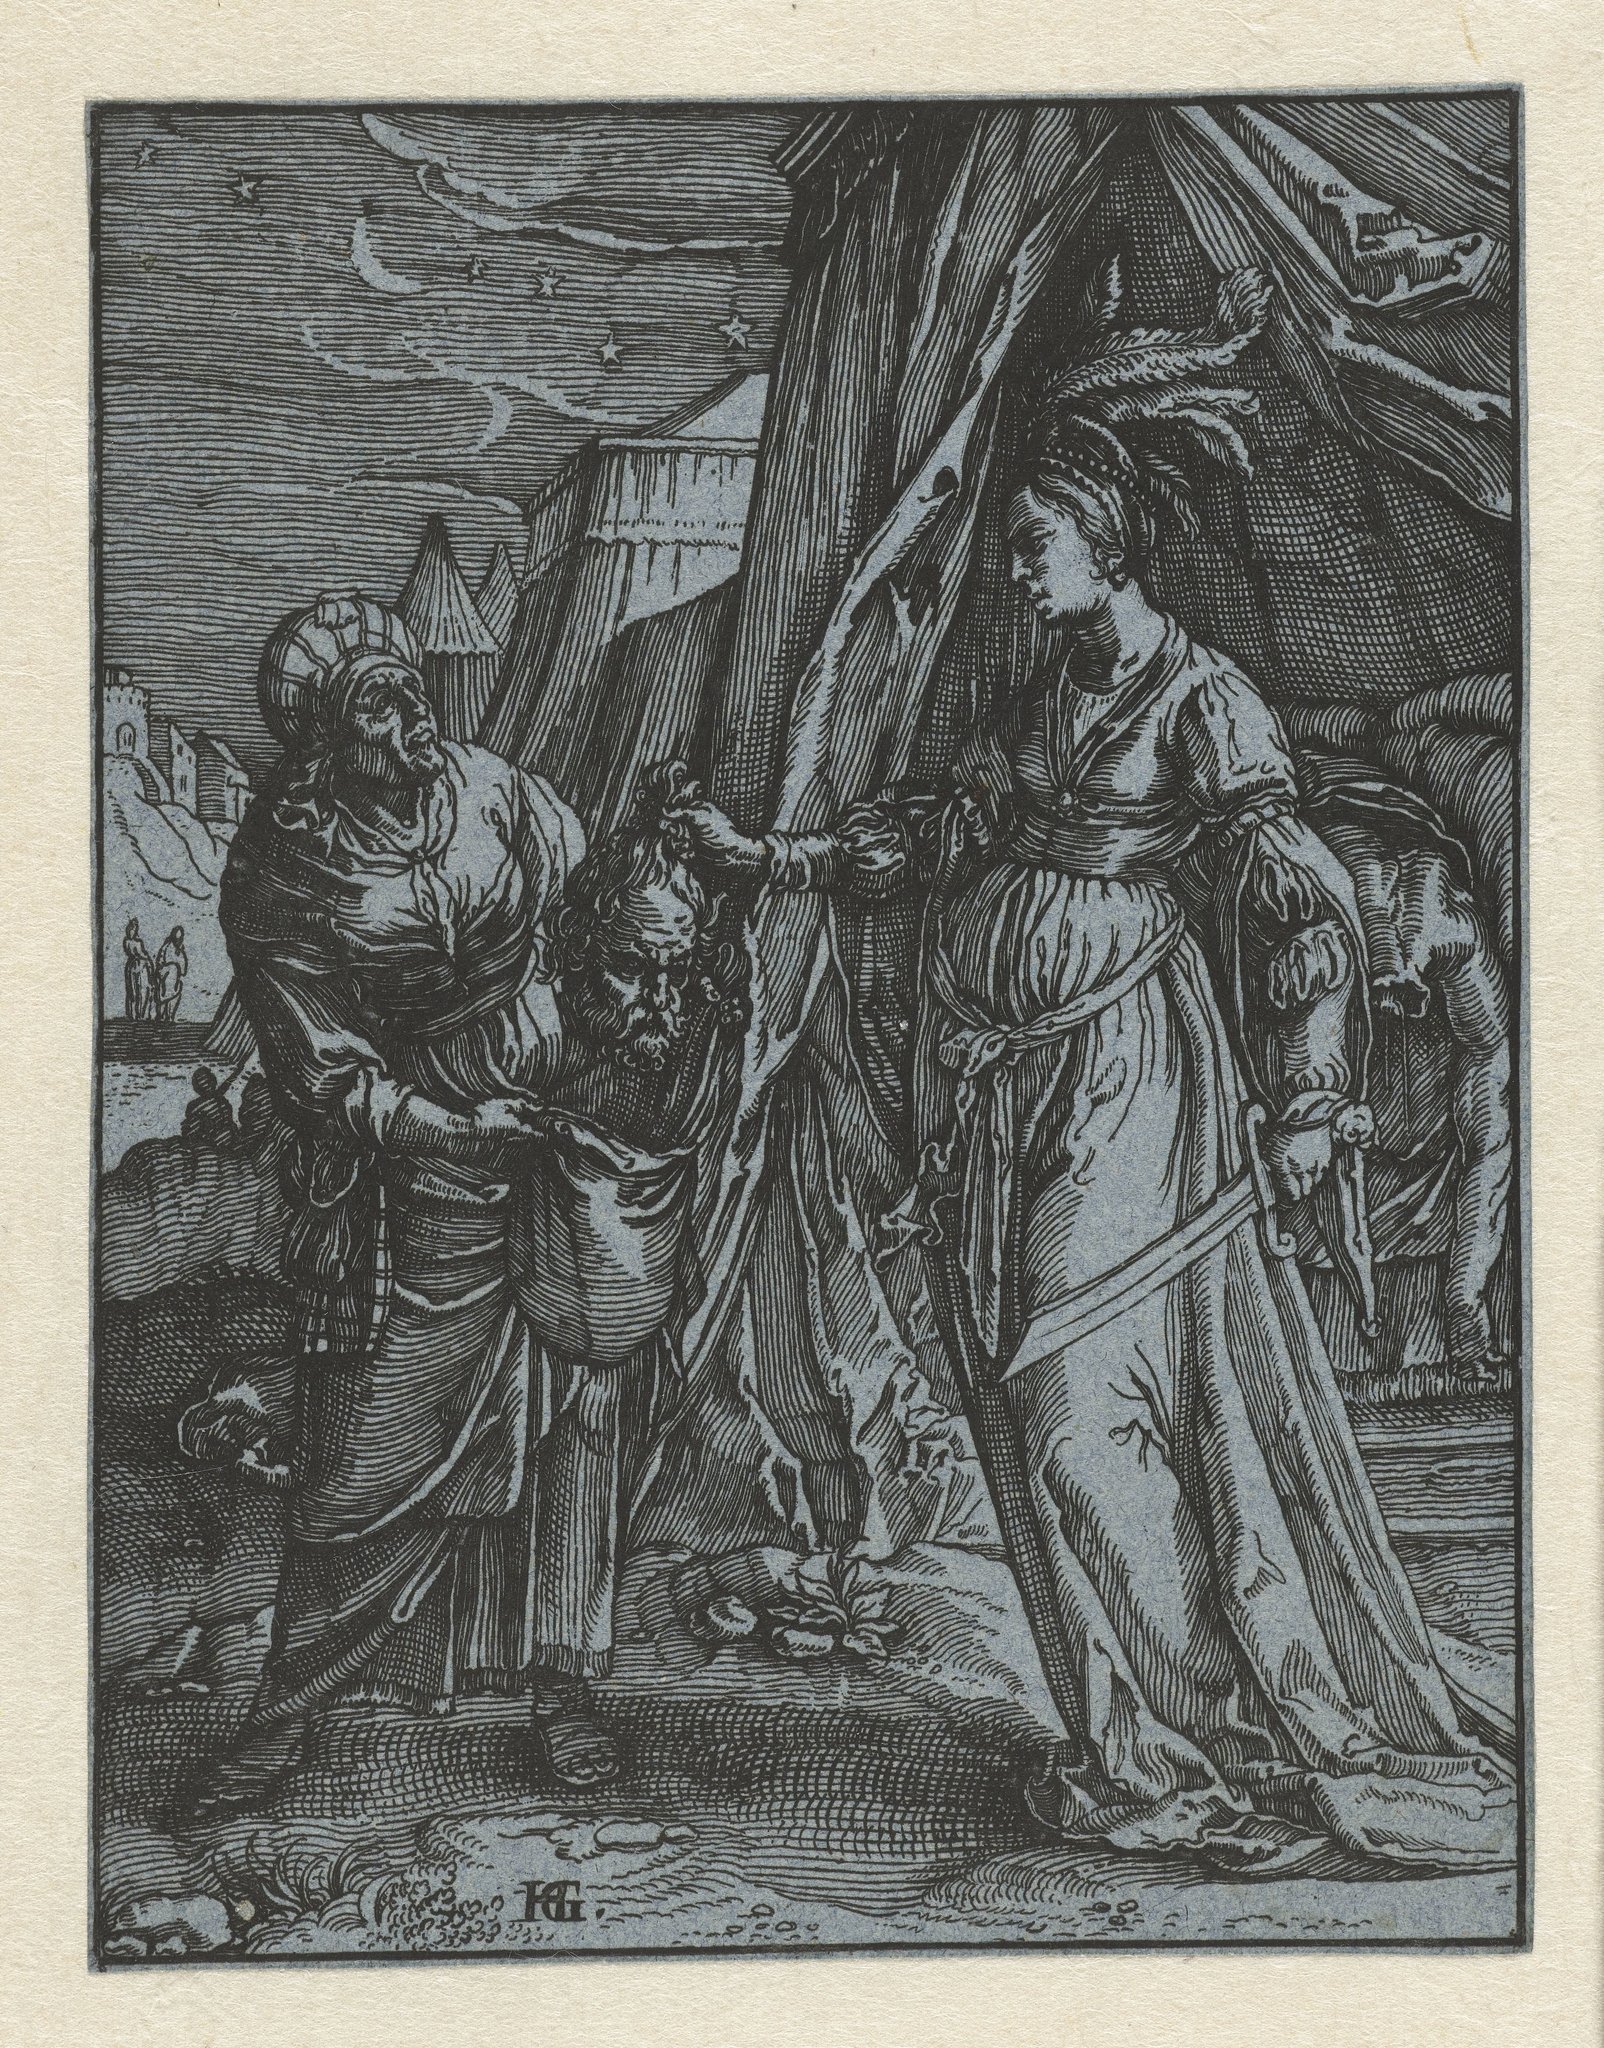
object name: print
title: Judith met het hoofd van Holofernes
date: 1600-1610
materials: paper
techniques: etching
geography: netherlands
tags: judith and holofernes (judith 8-16)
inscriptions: collector's mark: Lugt 240, collector's mark: Lugt 2228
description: Judith stopt het hoofd van Holofernes in de zak die haar dienstmaagd voor haar open houdt. Rechts achter hen, in zijn tent, het verminkte lijf van Holofernes.